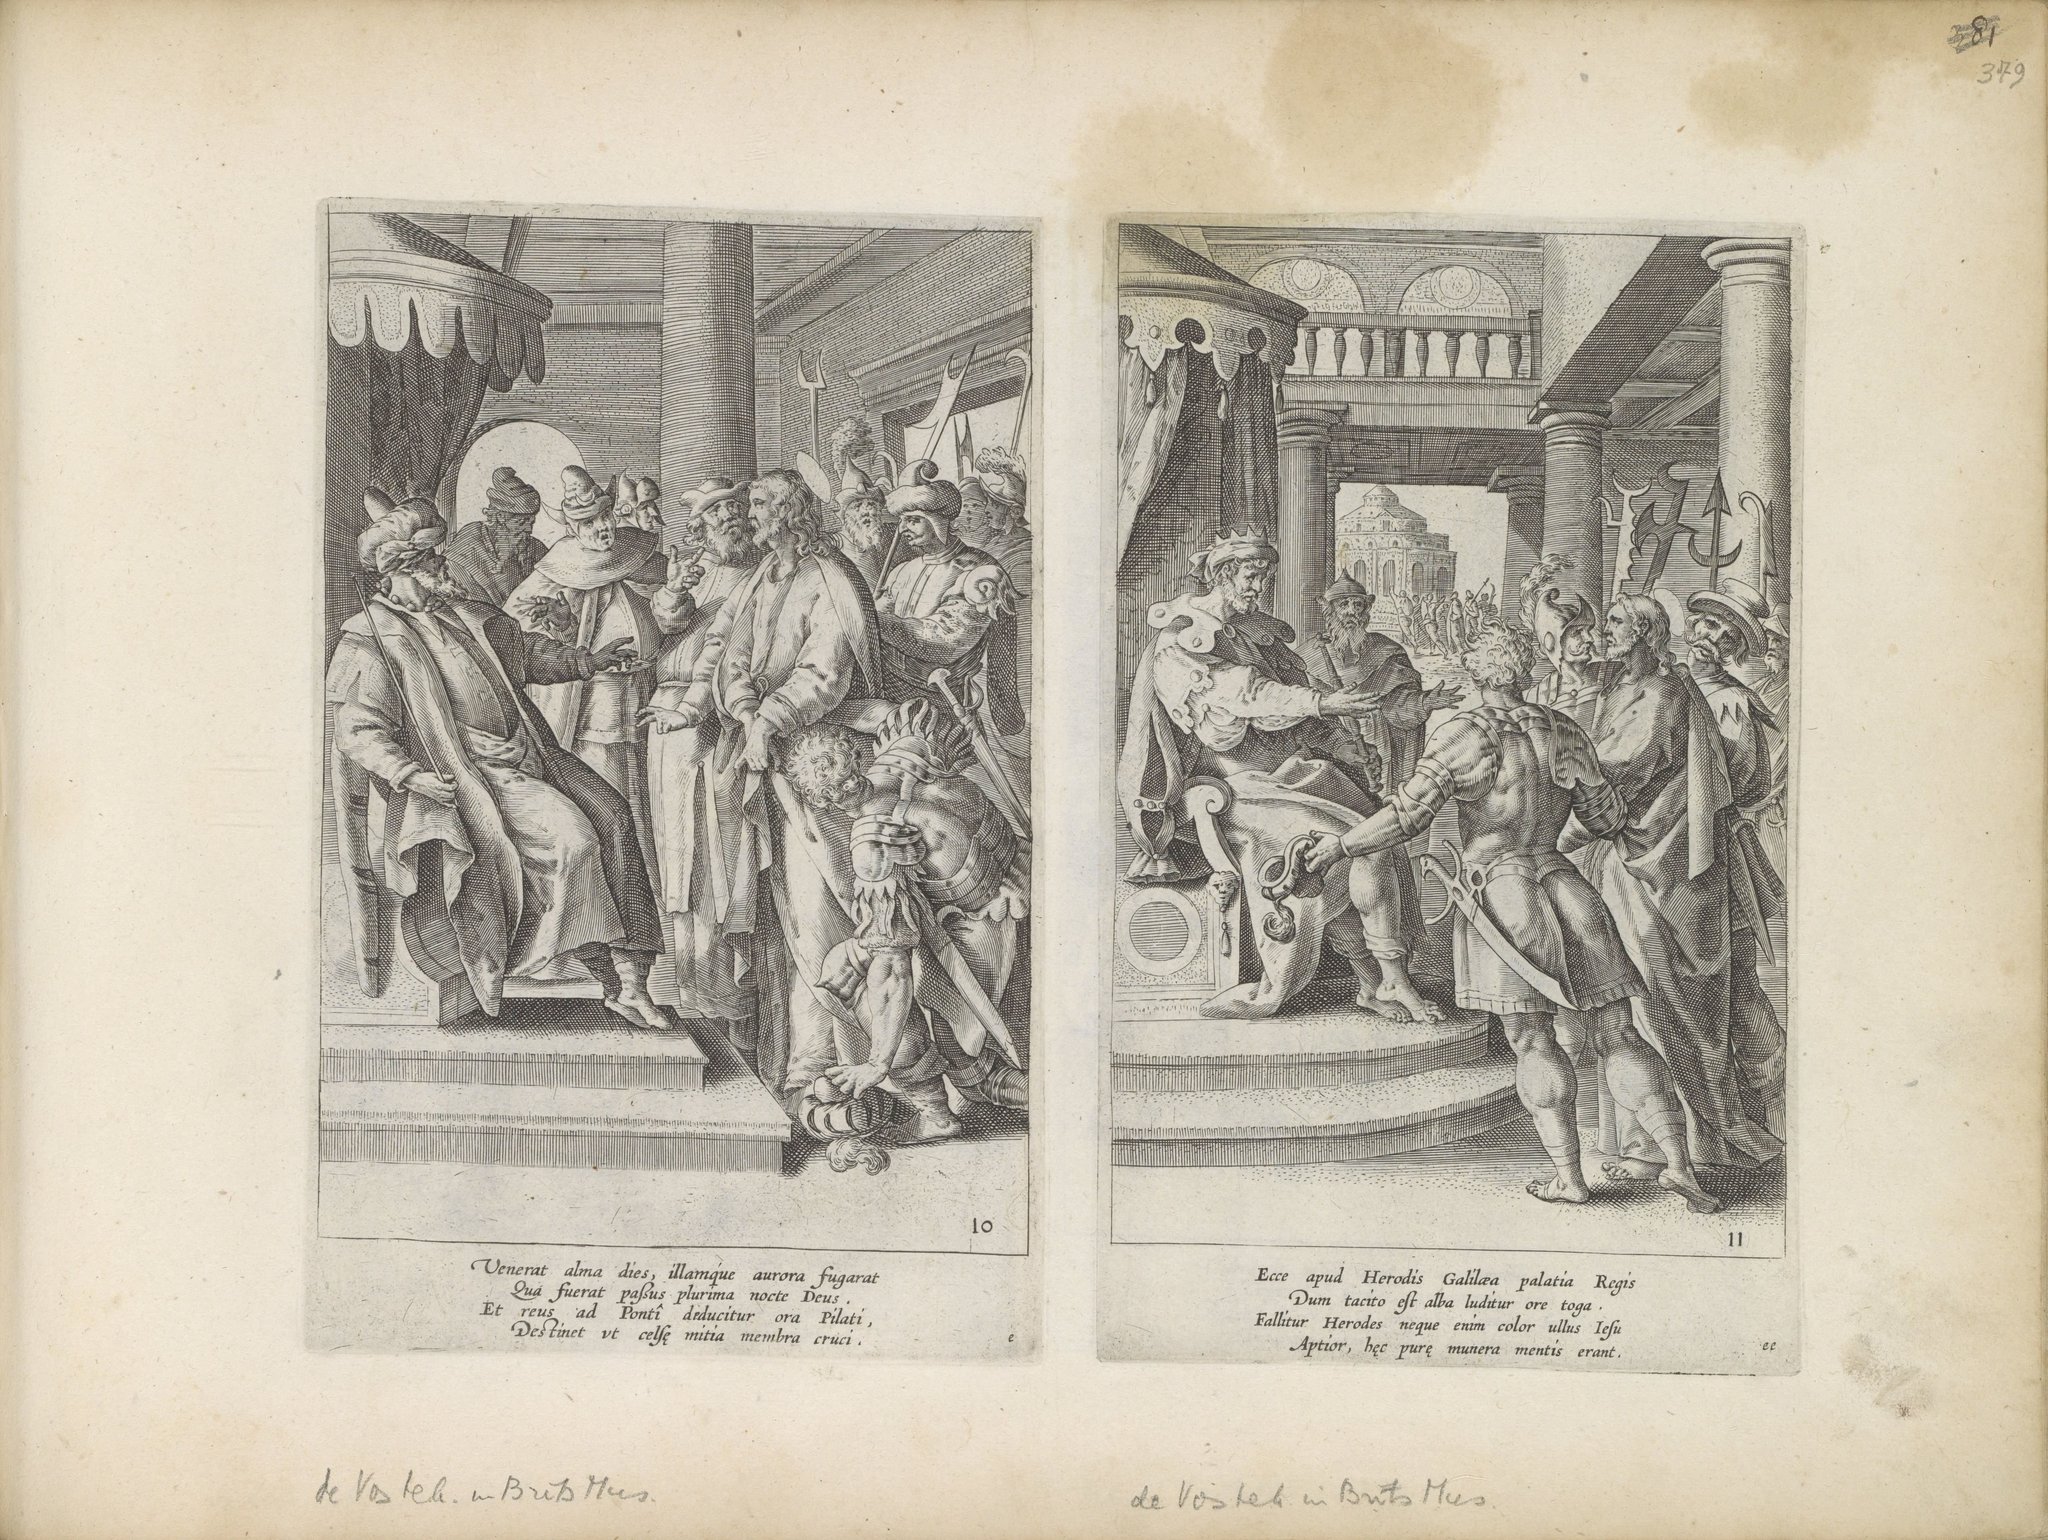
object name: album leaf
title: Christus voor Herodes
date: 1585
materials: paper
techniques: engraving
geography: amsterdam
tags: christ before king herod; sometimes a gorgeous robe is brought (luke 23:8-11)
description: Koning Herodes ondervraagt Christus, maar die antwoordt hem niet. Hierop bespotten Herodes en zijn soldaten Christus. Ze trekken hem een pronkgewaad aan. Onder de voorstelling een vierregelig vers in het Latijn. Rechtsonder de letters: ee. Deze prent maakt deel uit van een album.